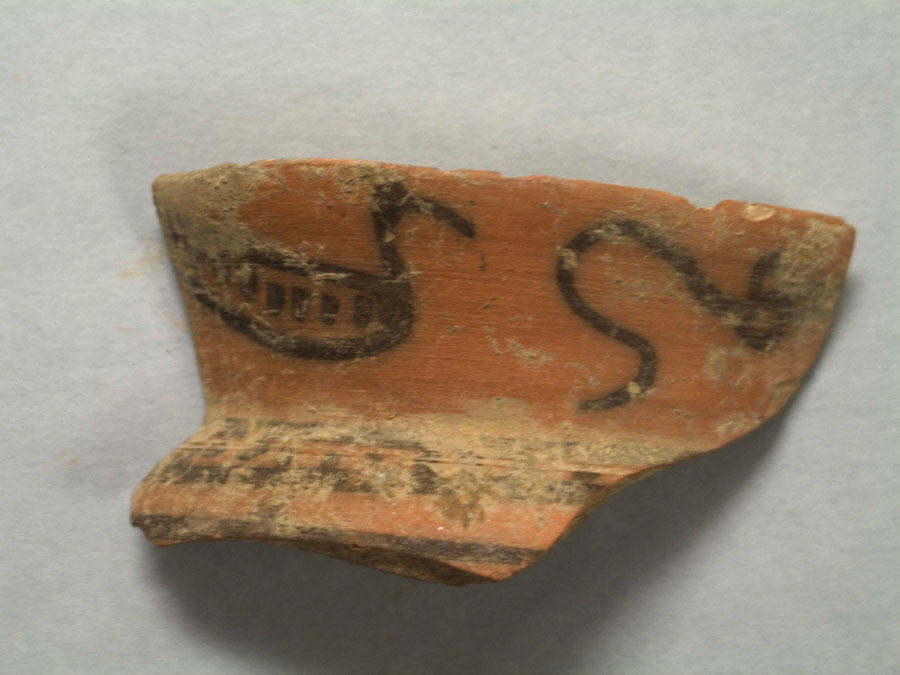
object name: shard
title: Shard: Neckpiece with Birds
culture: pakistani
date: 301-500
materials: terracotta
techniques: painting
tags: birds,gandhara